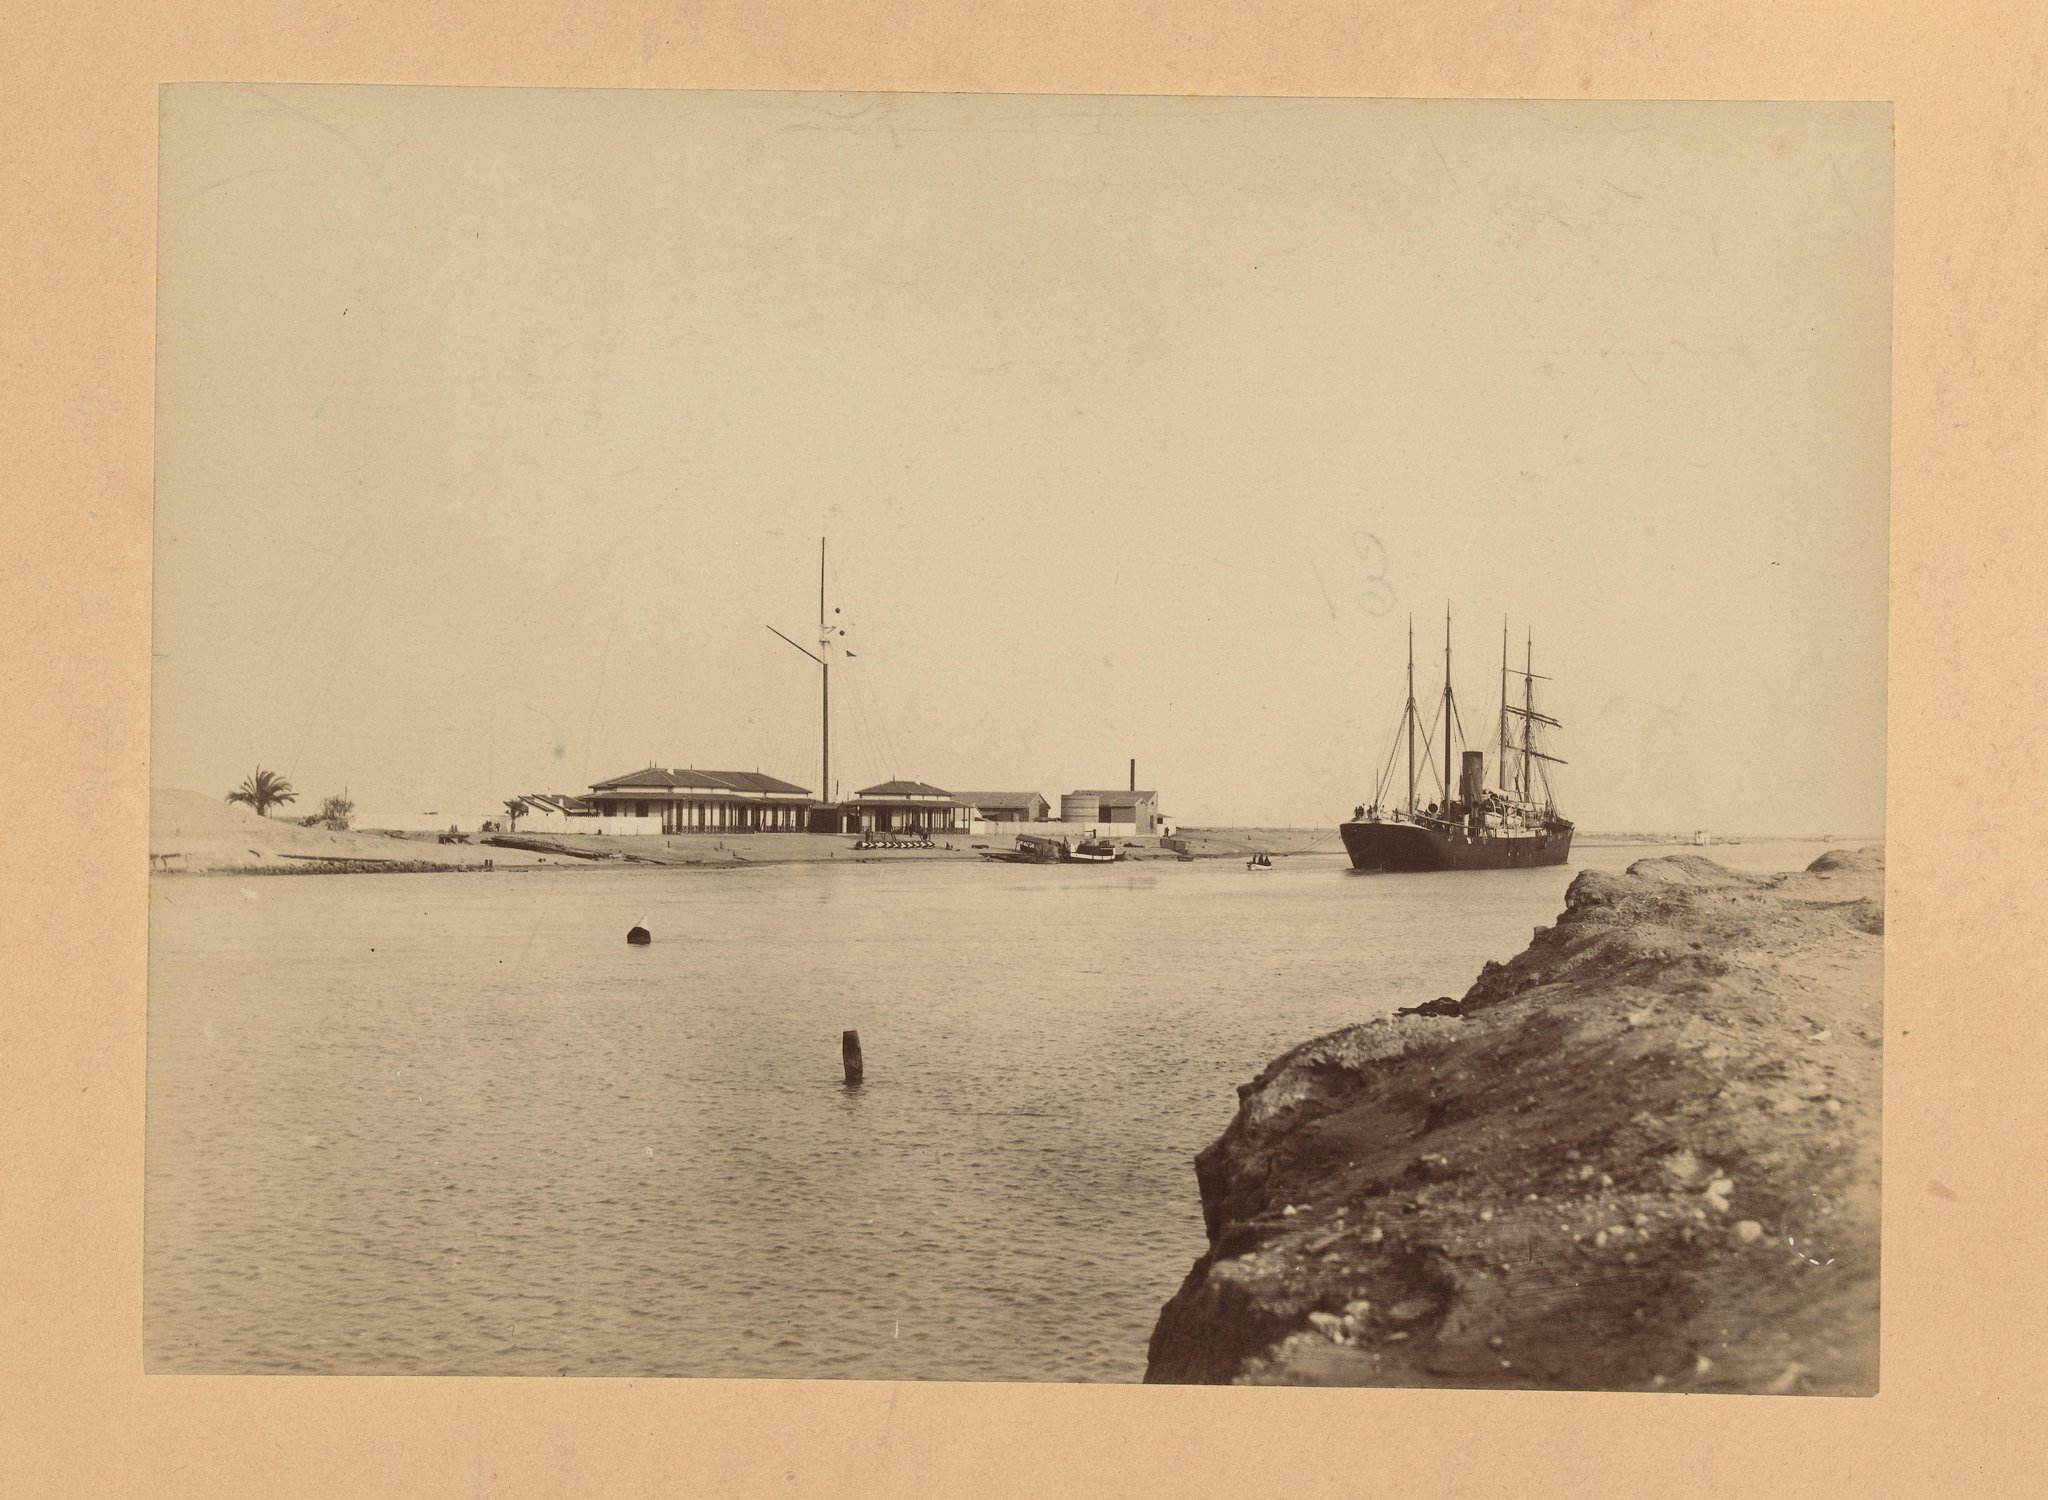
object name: photograph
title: Groep van 63 foto's van Egypte verzameld door Richard Polak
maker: richard polak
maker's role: fotograaf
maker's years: 1870-1957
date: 1862-1895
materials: paper, cardboard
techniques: albumen print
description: Groep van 63 foto's van Egypte verzameld door fotograaf Richard Polak. Deze foto's zijn samen met andere op zijn reizen verzamelde foto's tentoongesteld bij de Rotterdamsche Kunstkring (1895), Arti en Amicitiae te Amsterdam (1897-1898?) en Societeit 't Collegie te Kampen (datum vooralsnog onbekend).